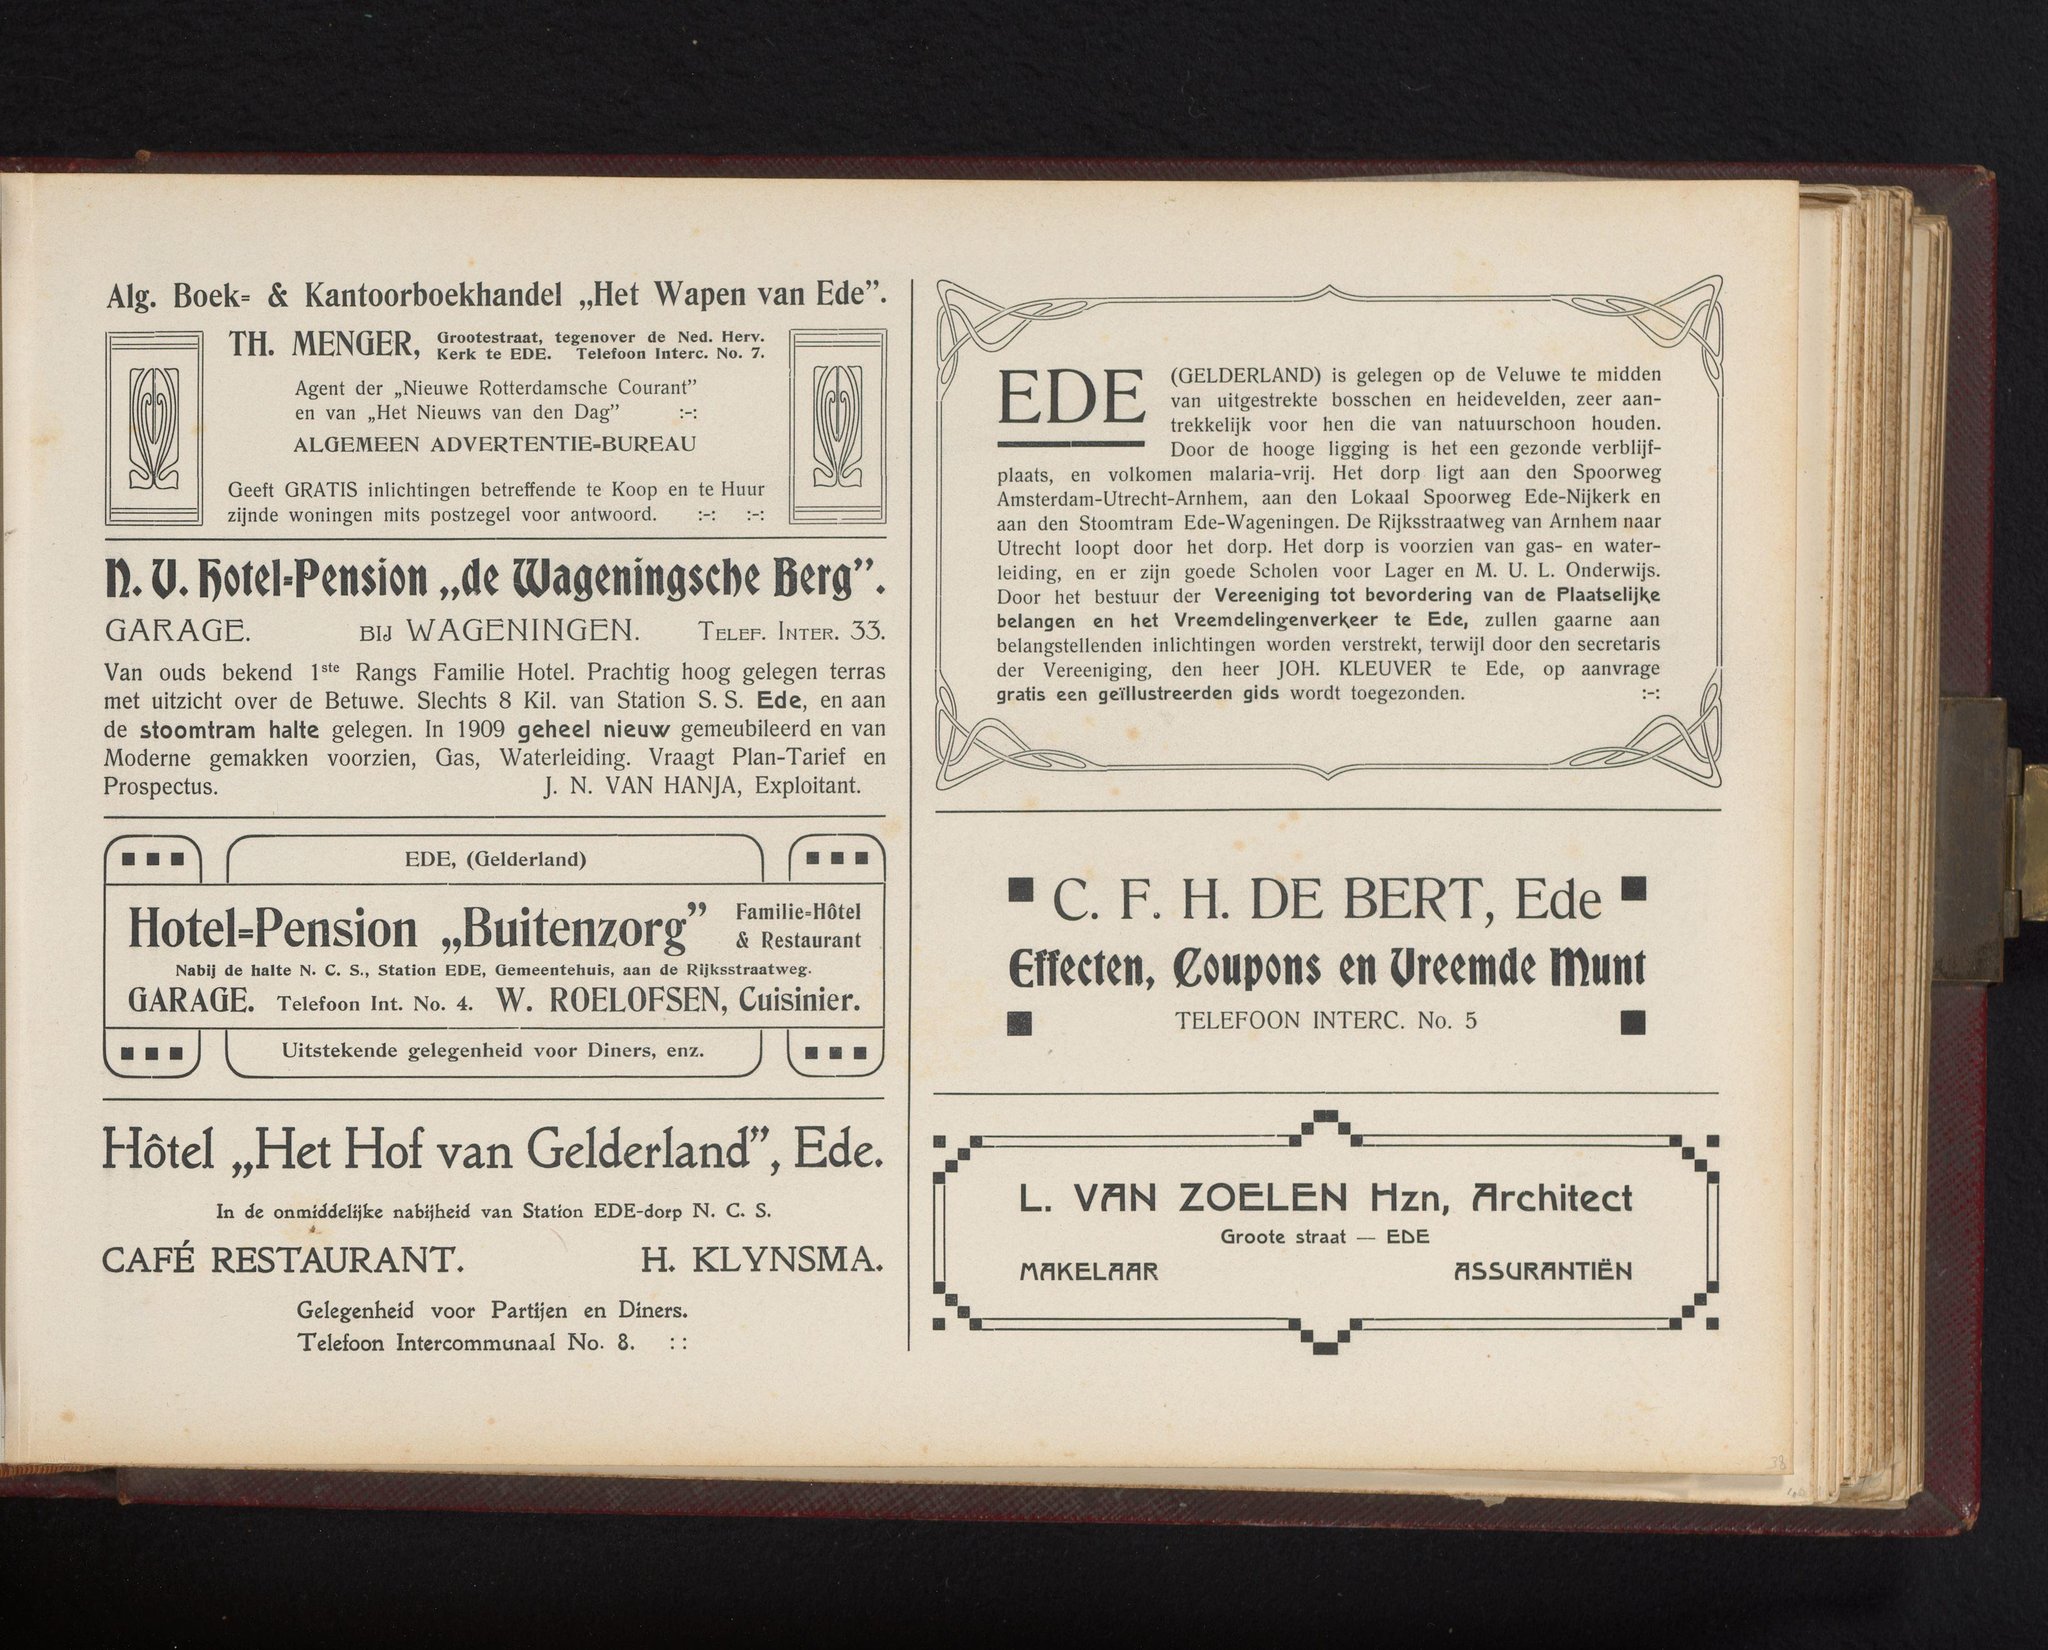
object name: album leaf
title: Advertenties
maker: Anonymous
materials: paper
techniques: printing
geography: netherlands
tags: advertising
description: Advertenties voor onder andere Alg Boek- & Kantoorhandel Het wapen van Ede Th. Menger, Vereeniging tot bevordering van de Plaatselijke belangen en het Vreemdelingenverkeer te Ede, N.V. Hotel-pension de Wagenische Berg, Hotel-pension Buitenzorg, Hôtel Het hof van Gelderland, C.F.H. De Bert en Architect L. van Zoelen. Deze pagina maakt deel uit van een album.